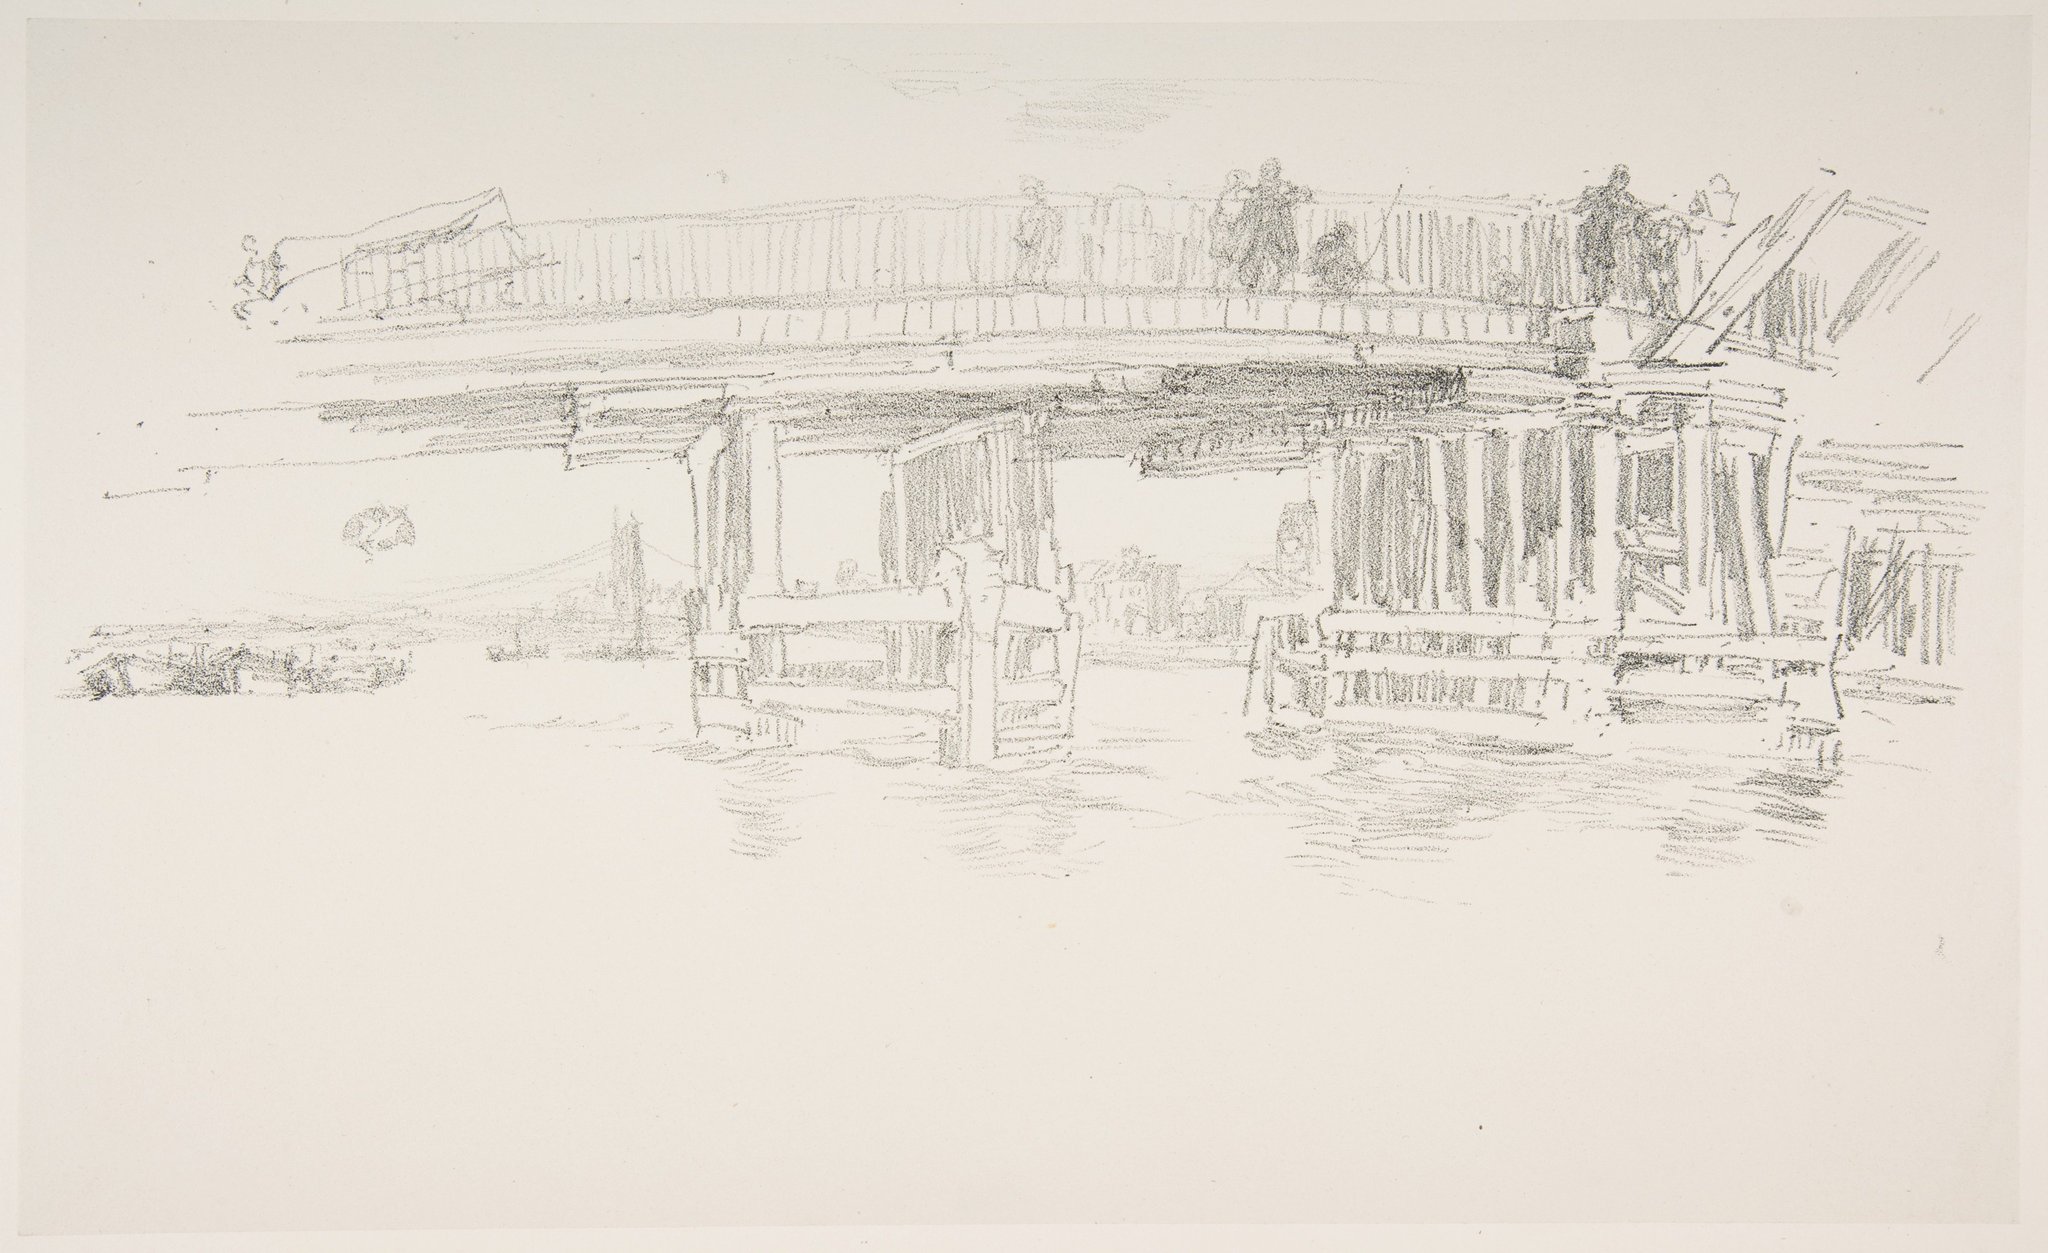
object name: print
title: Old Battersea Bridge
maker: james mcneill whistler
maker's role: artist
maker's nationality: american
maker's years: 1834-1903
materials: ink, ivory, paper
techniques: lithograph, printing, scraping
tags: bridges